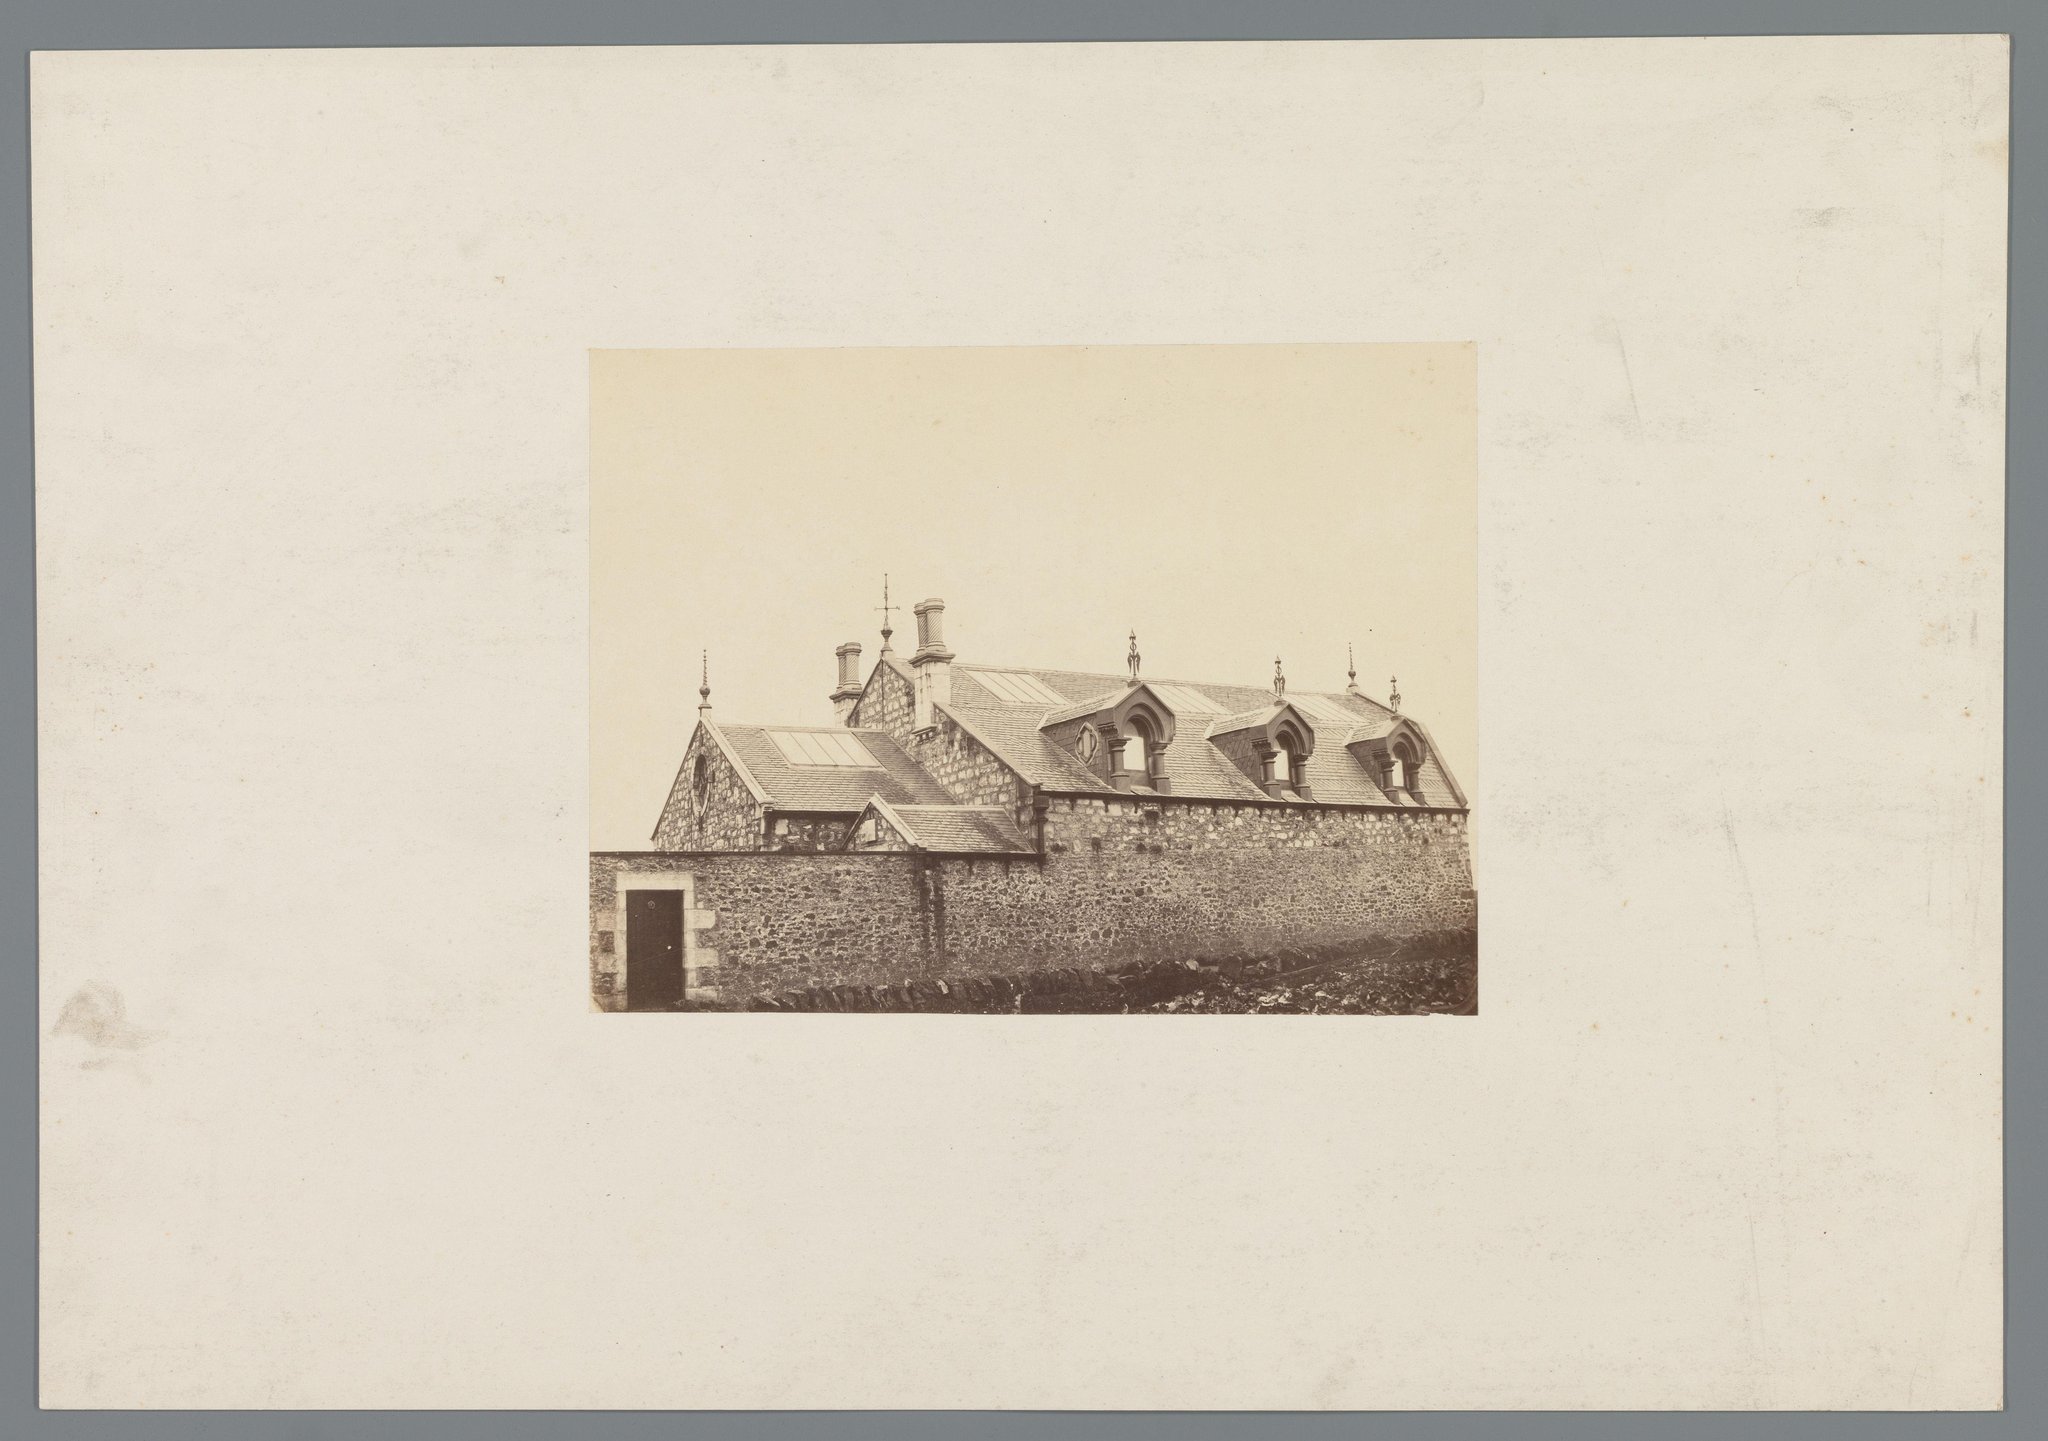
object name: photograph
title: Gezicht op landhuis in Engeland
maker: Anonymous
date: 1875-1885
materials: cardboard, paper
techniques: albumen print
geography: england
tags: farm or solitary house in landscape, england